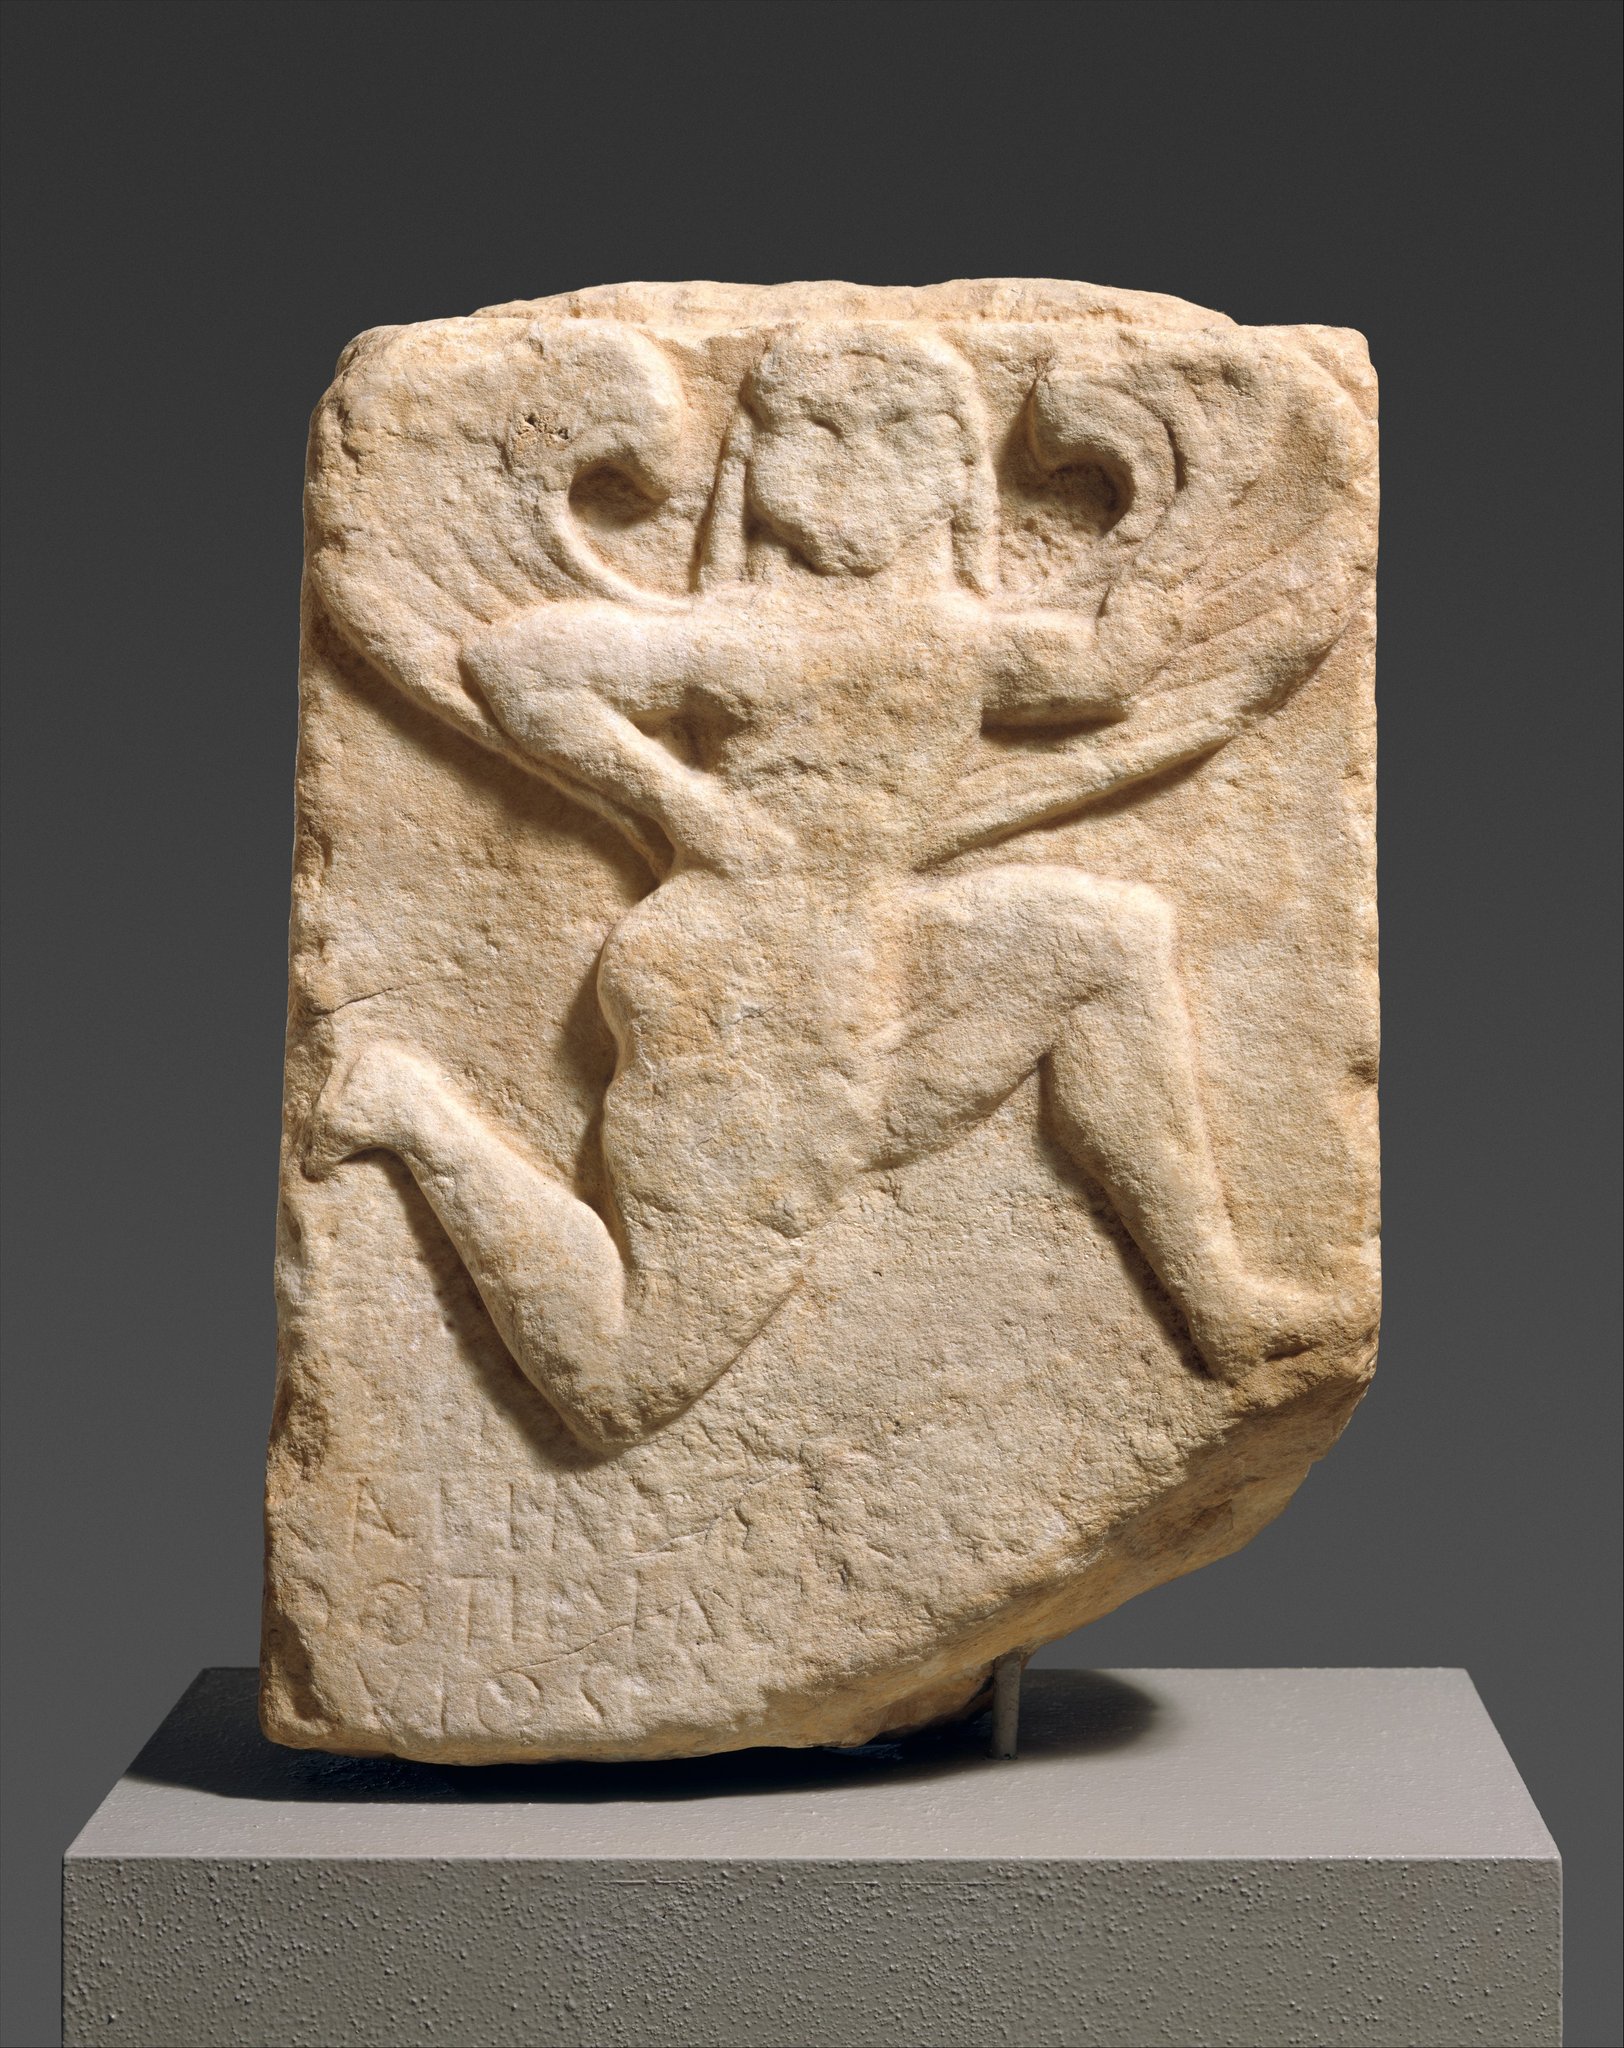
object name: grave stele of kalliades, fragment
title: Part of the marble stele (grave marker) of Kalliades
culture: greek, attic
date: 550-525 BCE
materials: marble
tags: gorgons